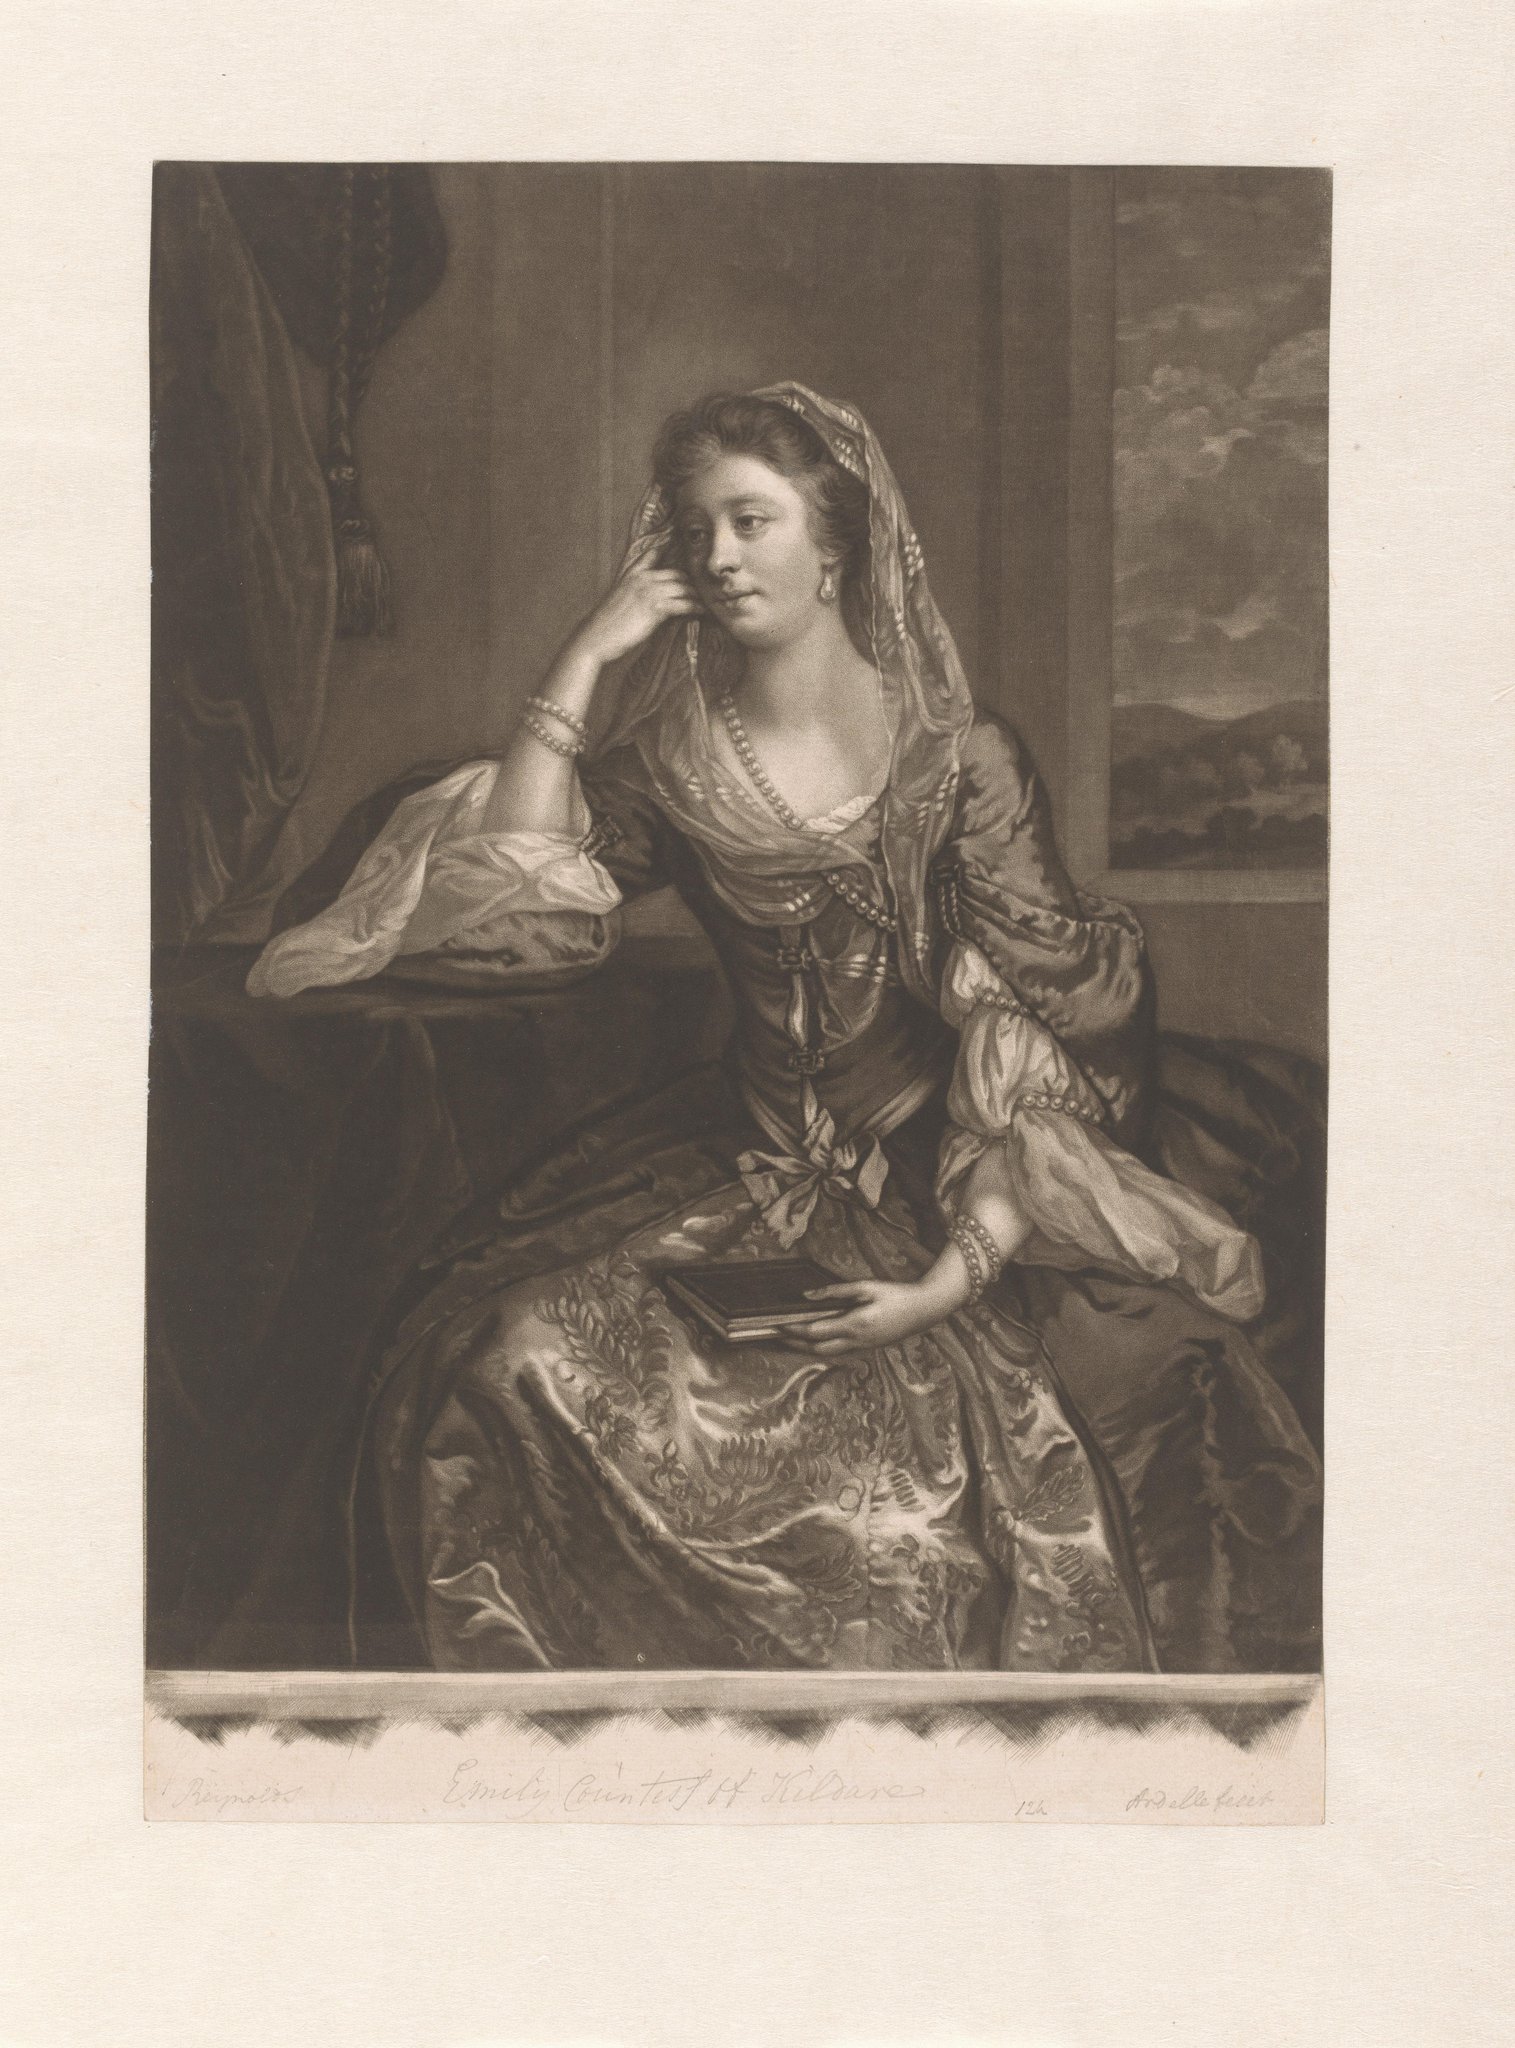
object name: print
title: Portret van Emily FitzGerald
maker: james mcardell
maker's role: print maker, publisher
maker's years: 1728-1765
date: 1754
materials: paper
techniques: mezzotint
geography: london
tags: historical persons - bb - woman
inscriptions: inscription: ‘Reynolds Emily Countess of Kildare Ardelle fecit’, collector's mark: Lugt 240